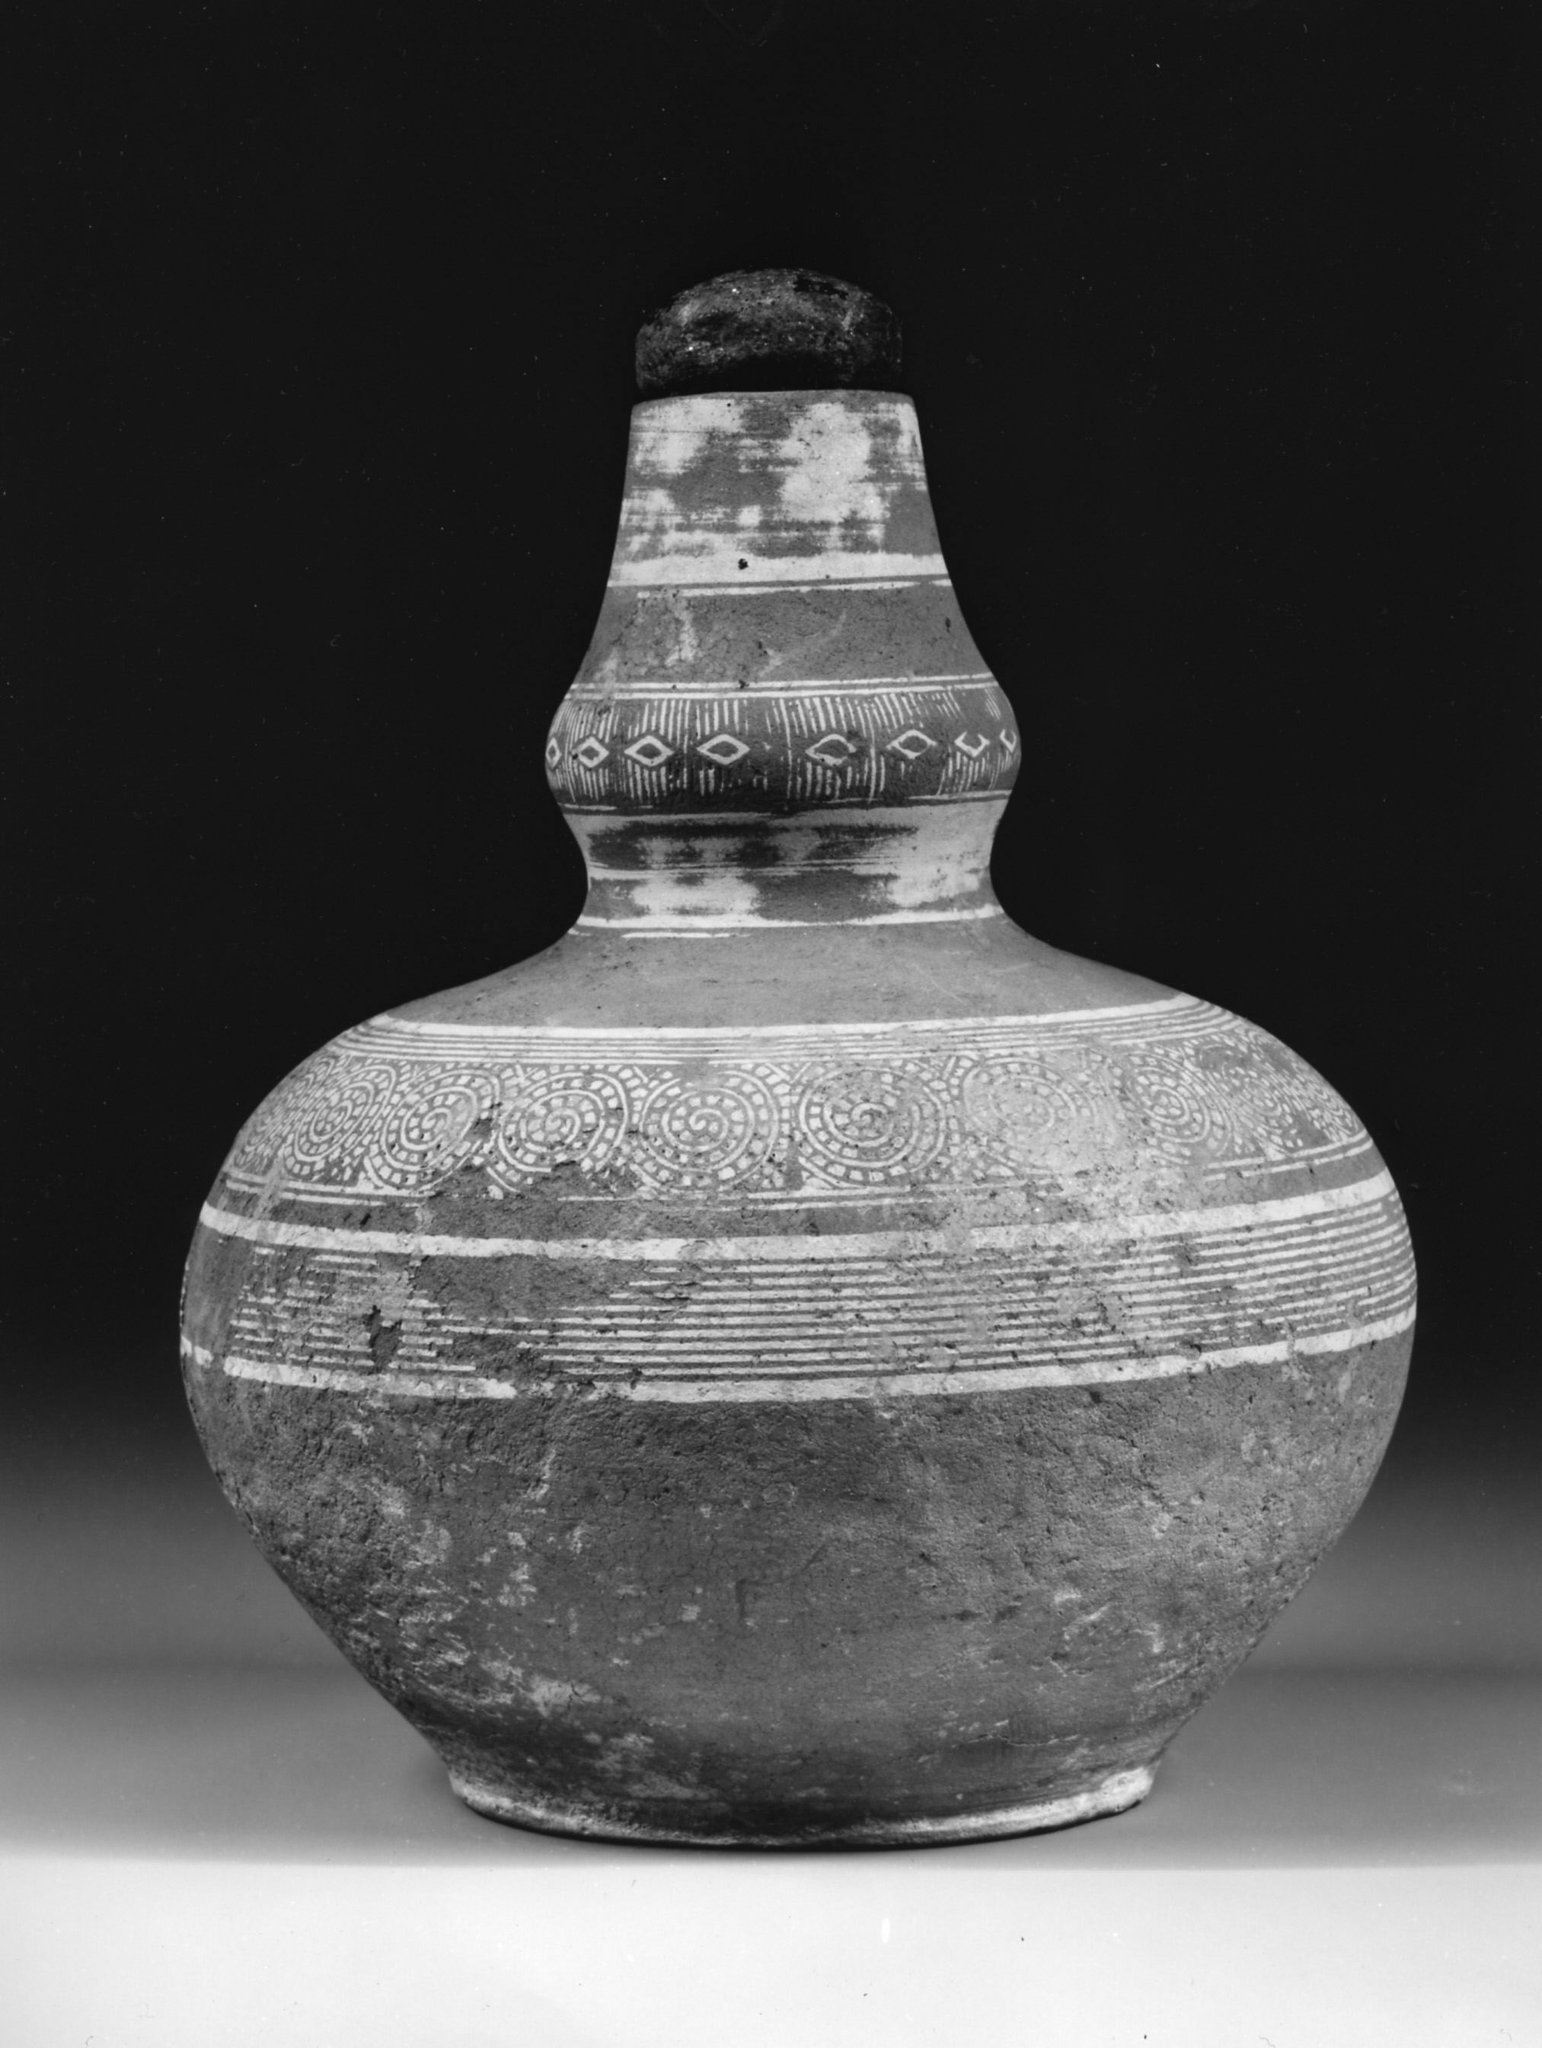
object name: bottle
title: Bottle with Stopper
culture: thai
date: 1301-1400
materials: terracotta